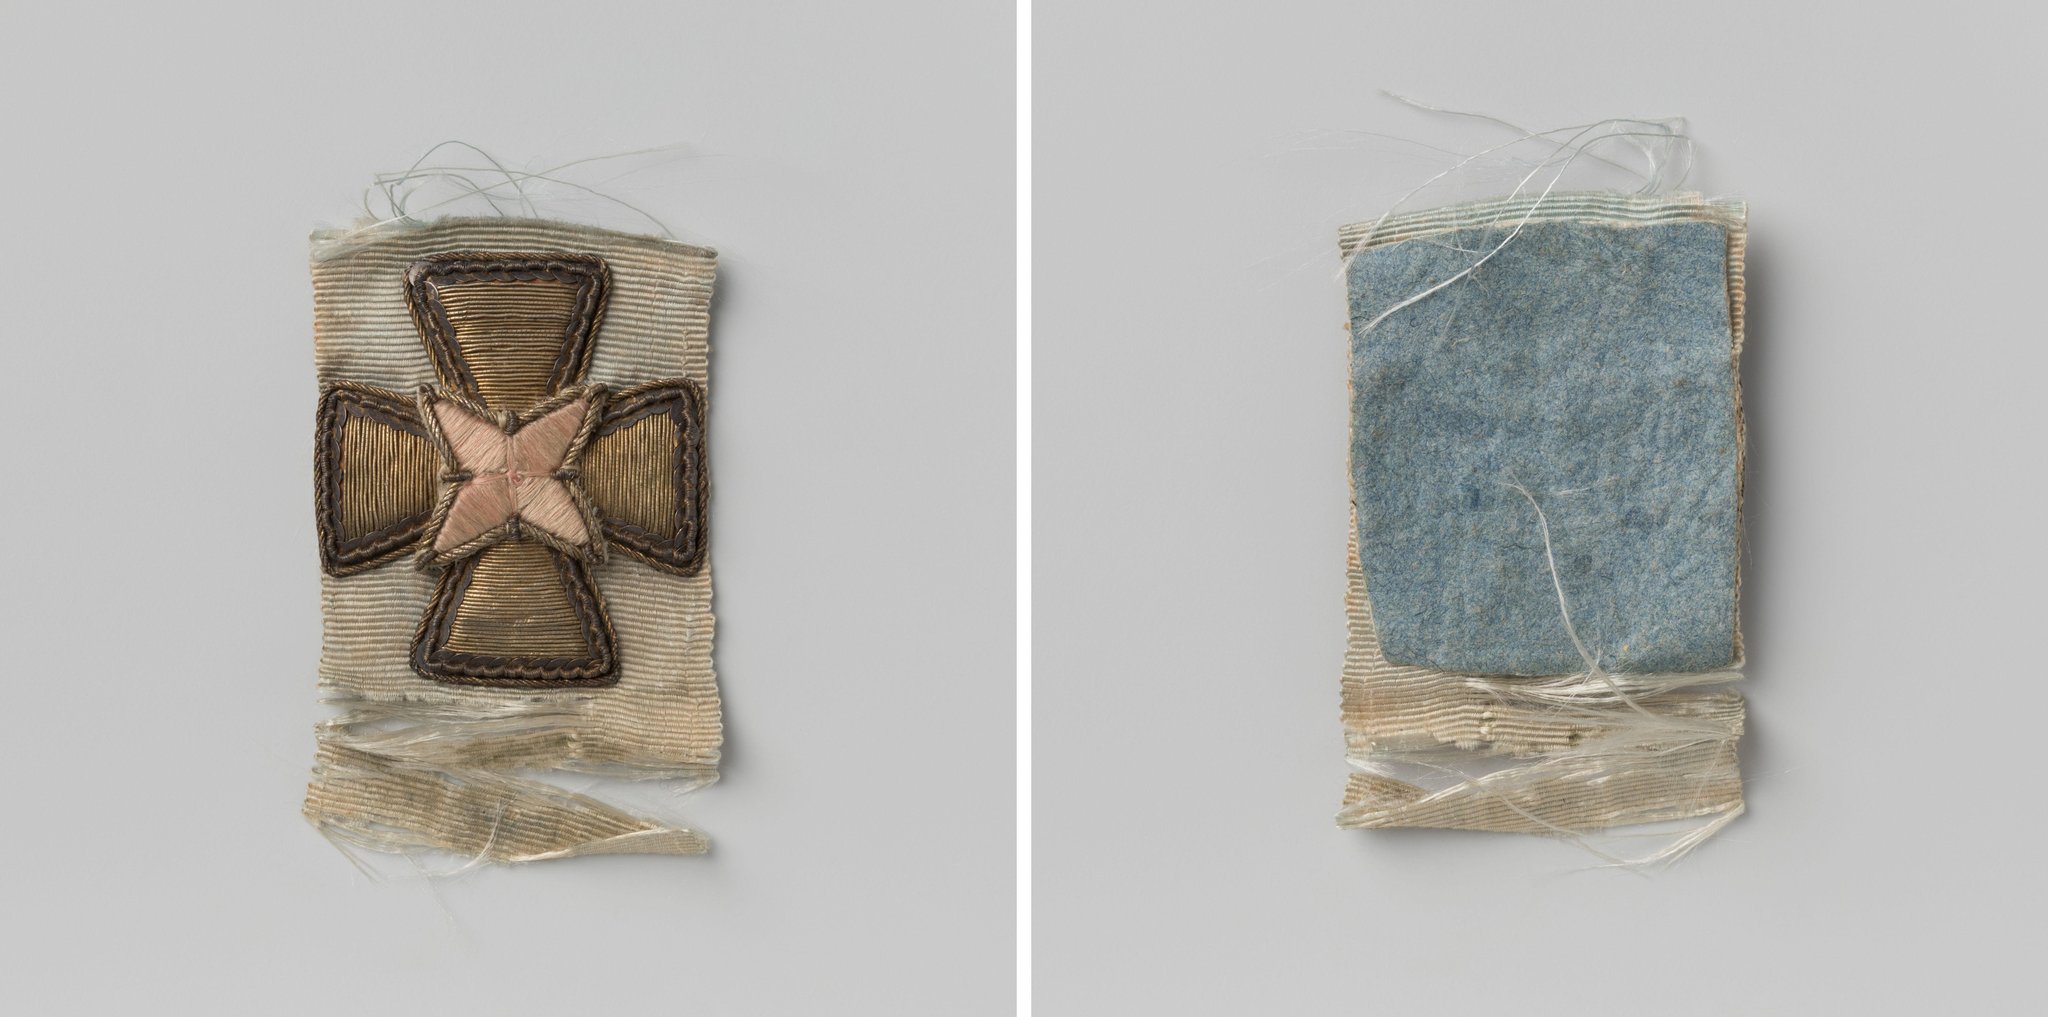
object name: insignia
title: Schermvereniging, insigne van schermmeester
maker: Anonymous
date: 1800-1880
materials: textile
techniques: embroidered, sewing